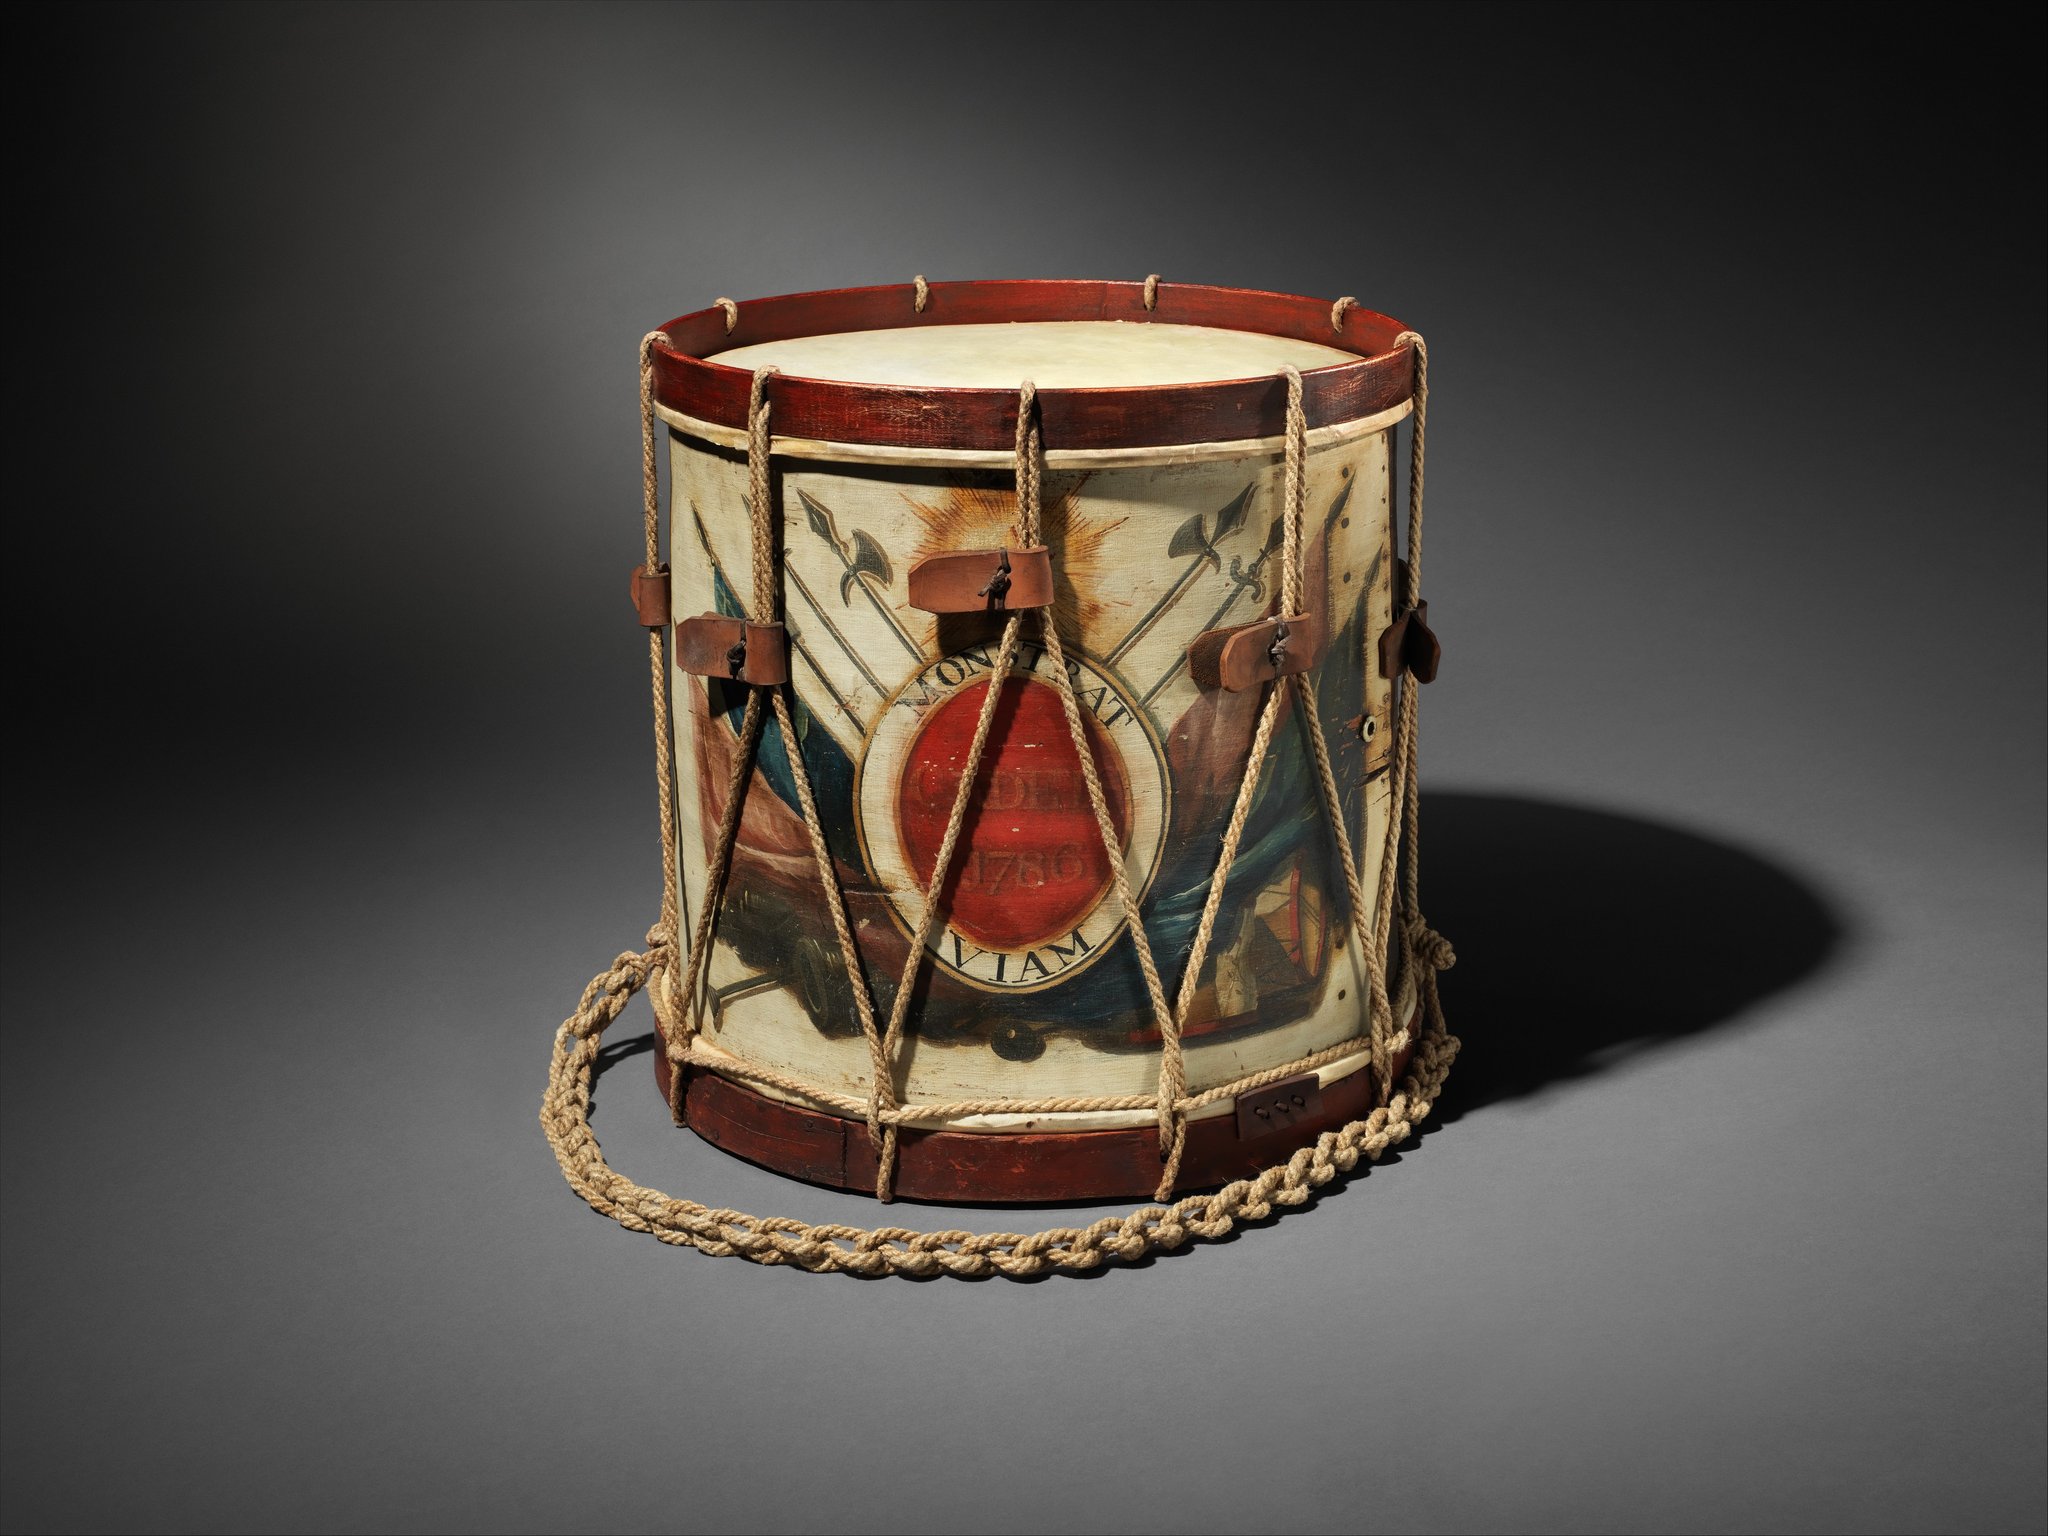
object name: side drum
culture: american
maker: henry h. prentiss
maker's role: maker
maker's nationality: american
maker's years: 1801-1860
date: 1840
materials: leather, paint, fiber, skin, wood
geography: united states